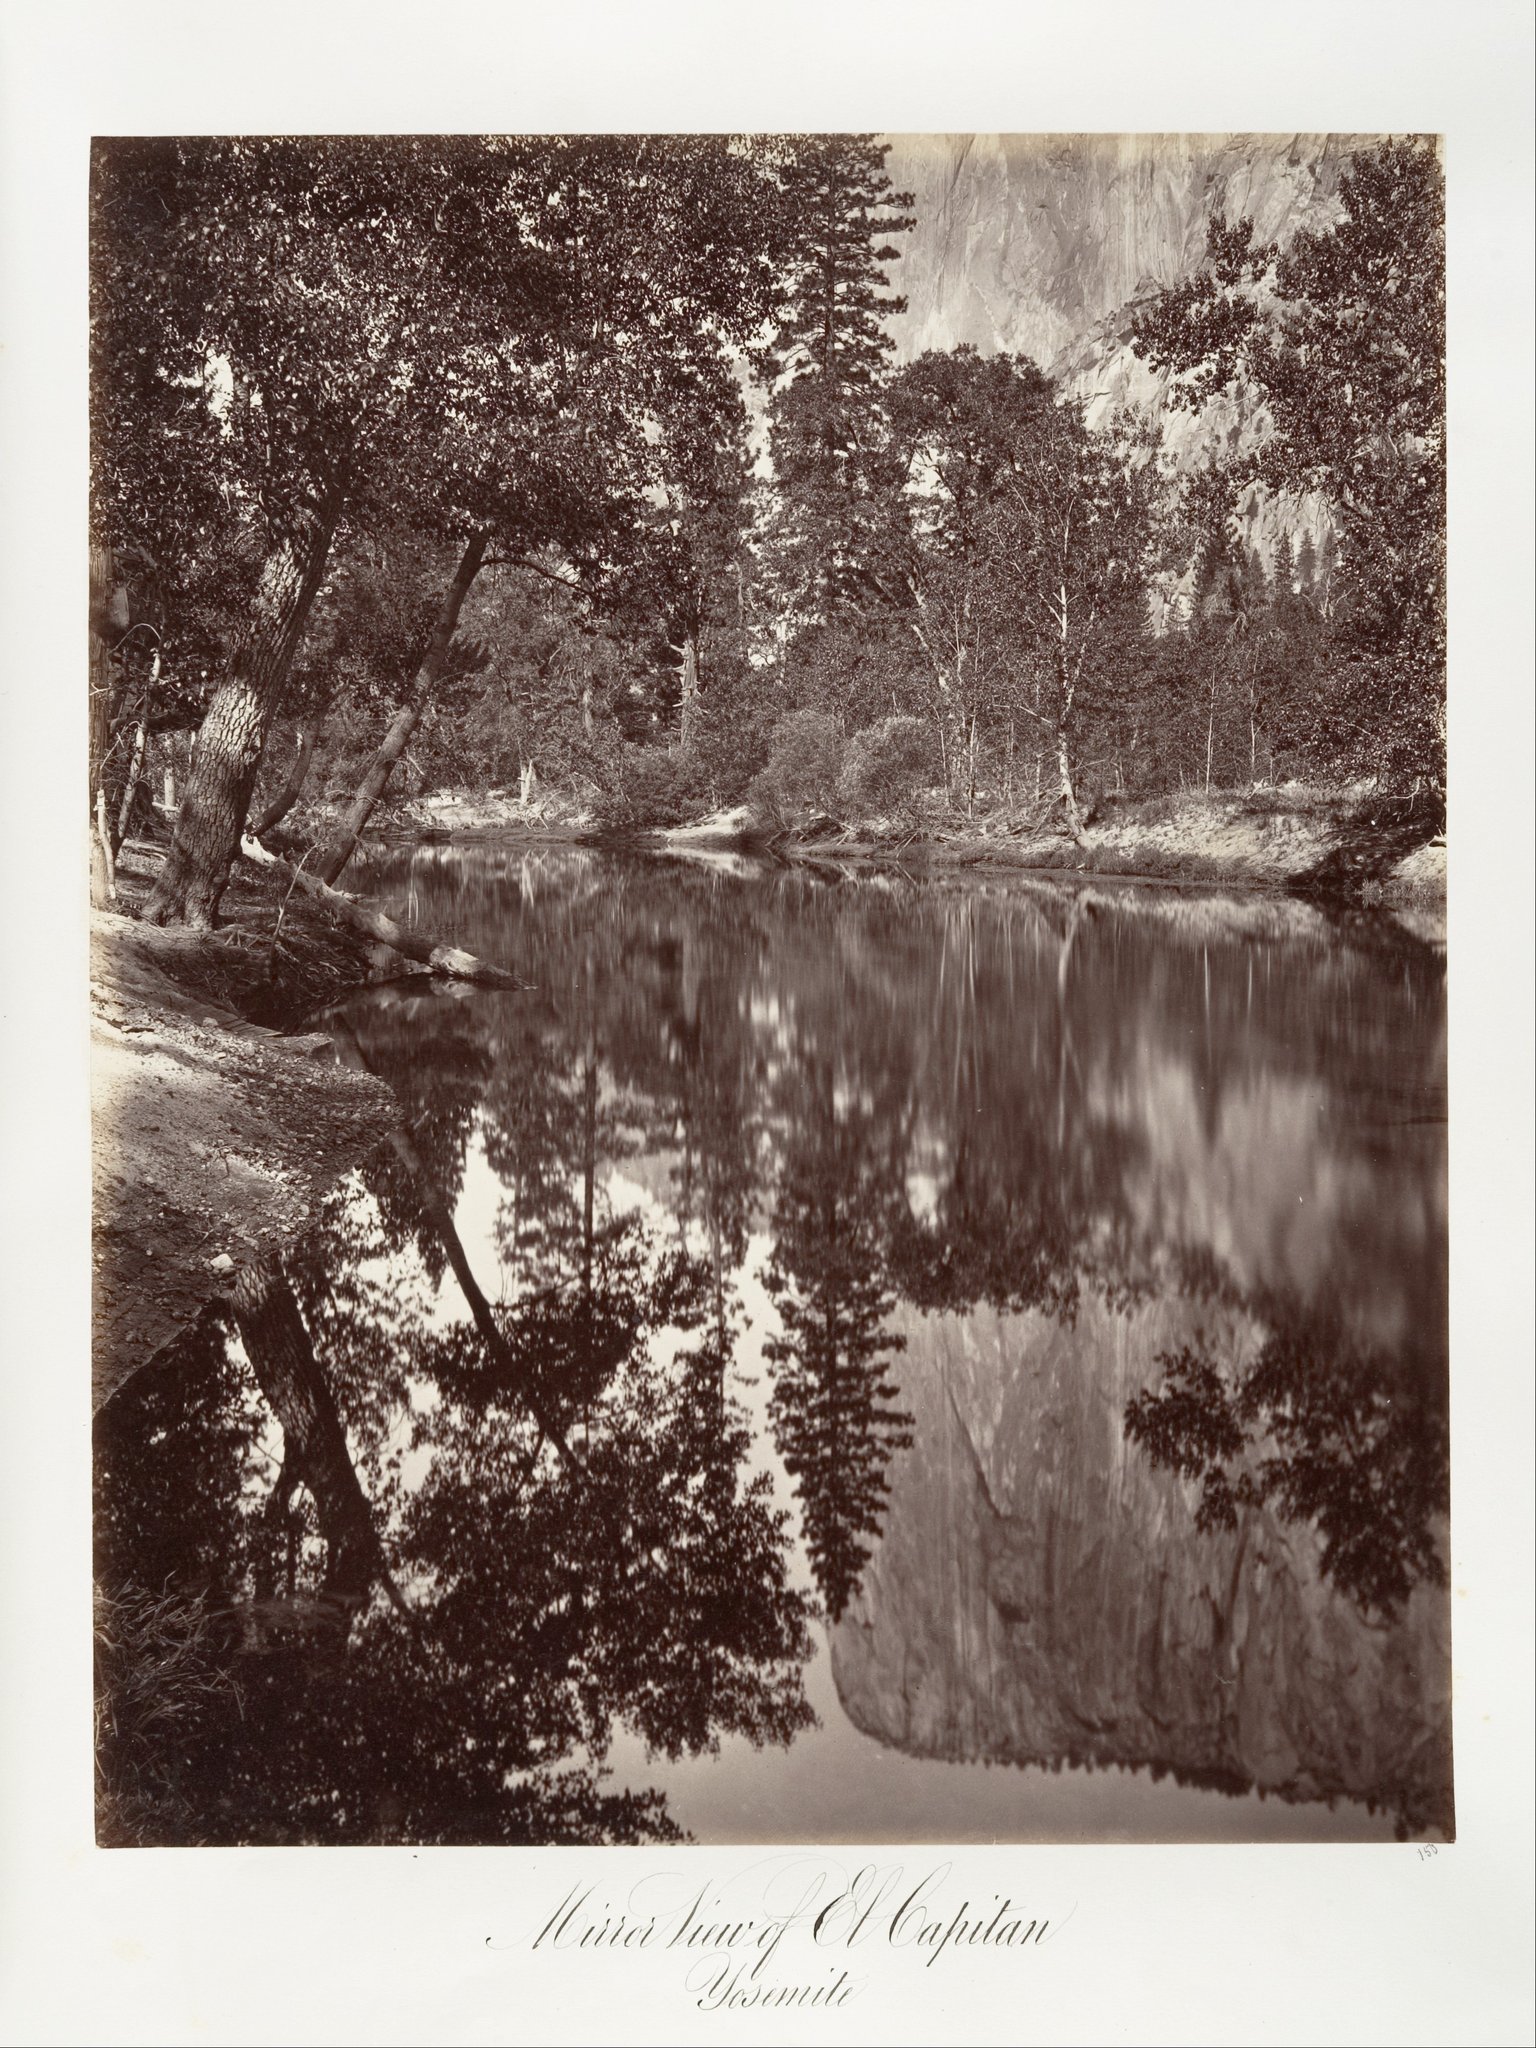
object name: photograph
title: Mirror View of El Capitan, Yosemite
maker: carleton e. watkins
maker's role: artist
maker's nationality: american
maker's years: 1829-1916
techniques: albumen silver print, glass negative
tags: rivers,mountains,landscapes